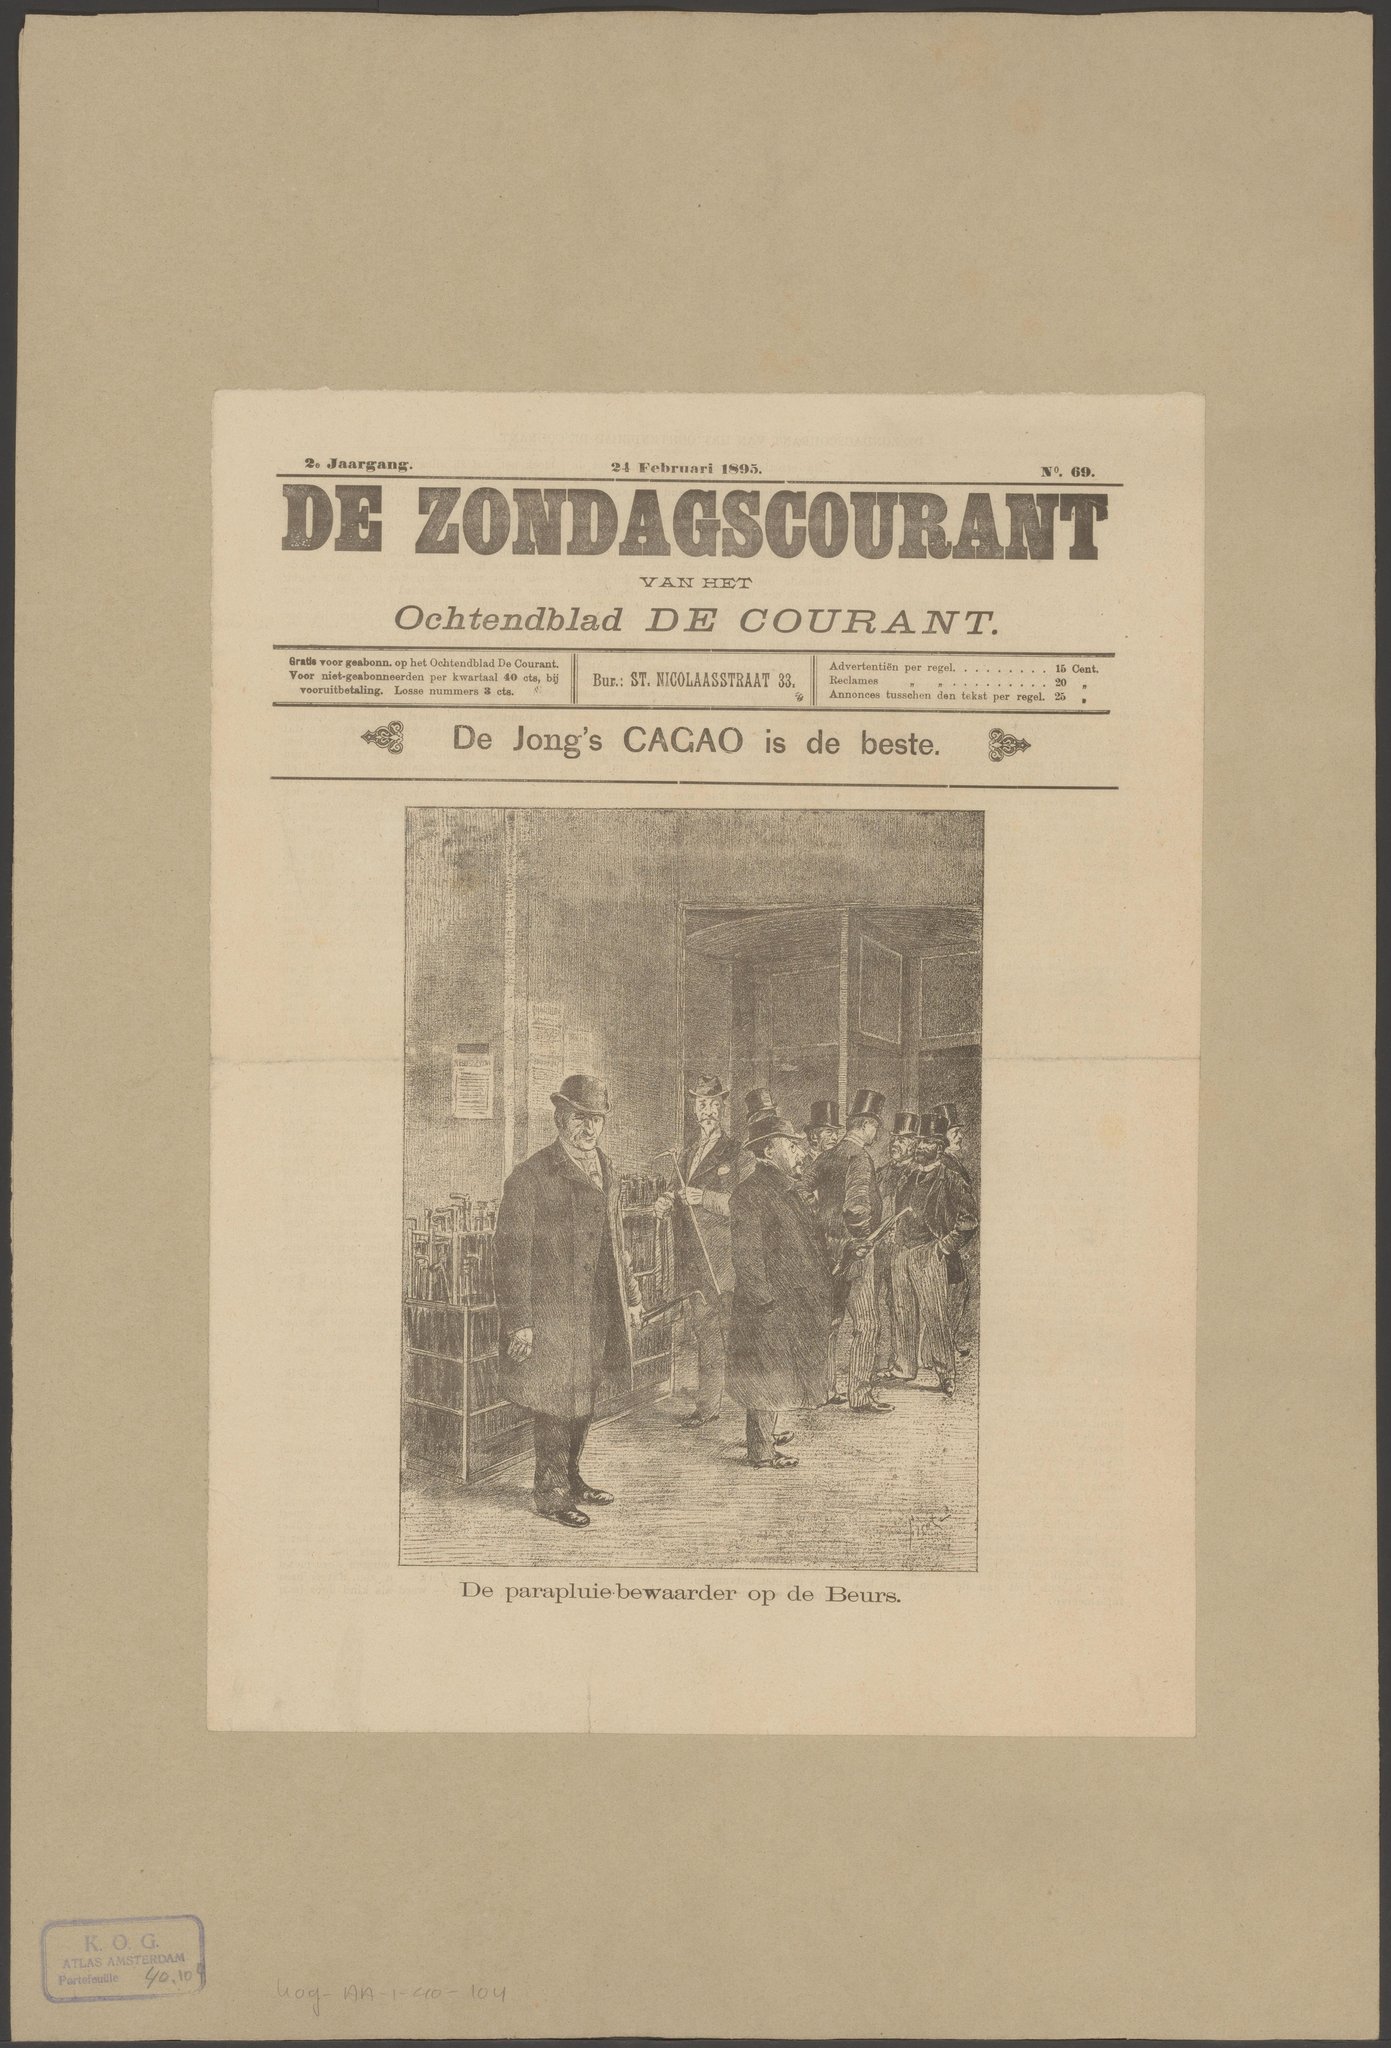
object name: titelblad, titelpagina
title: Mannen bij een bak met wandelstokken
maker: Anonymous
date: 1895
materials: paper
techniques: letterpress printing, lithograph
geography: netherlands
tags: walking-stick, staff, stock exchange, stock-market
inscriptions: signature: ‘Ficot (?)’, collector's mark: Lugt 1641b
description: Titelpagina voor: De Zondagscourant van het Ochtendblad De Courant 2 (1895), nr. 69, 24 februari 1895.